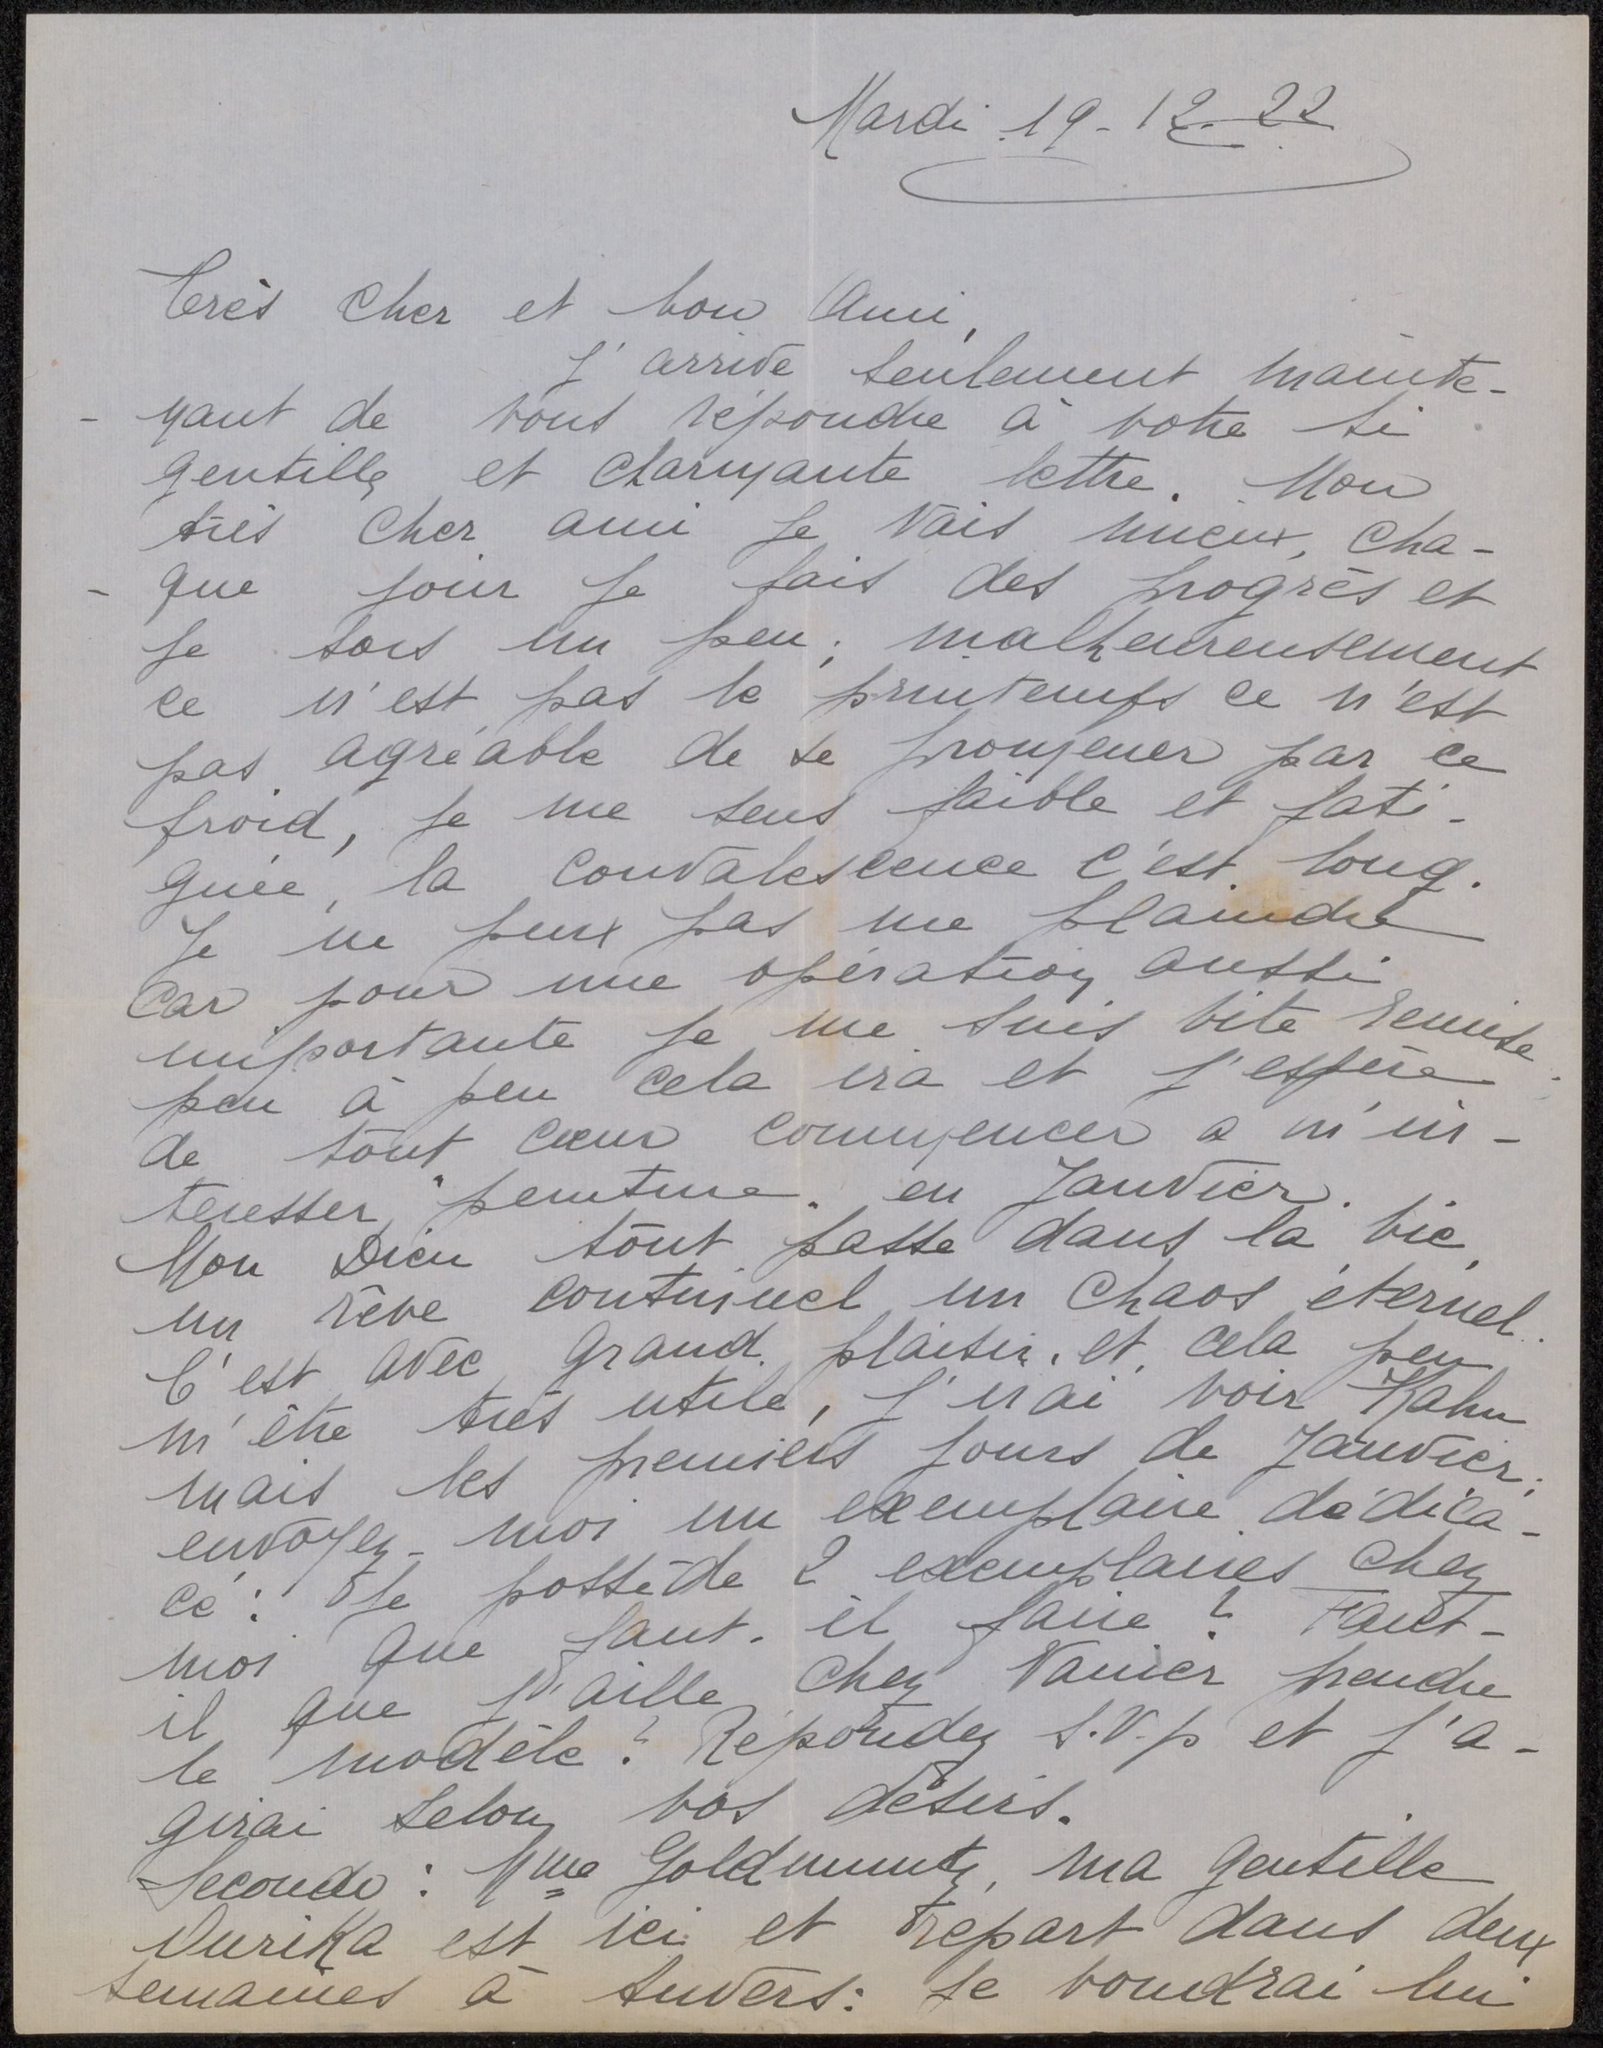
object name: letter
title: Brief aan Philip Zilcken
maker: rose imel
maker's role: draughtsman, painter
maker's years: 1901-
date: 1922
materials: ink, paper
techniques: pen, writing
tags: paris, print maker, draughtsman, auguste rodin, h. goldmuntz, painter, philip zilcken, diseases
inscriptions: collector's mark: ‘RPK’